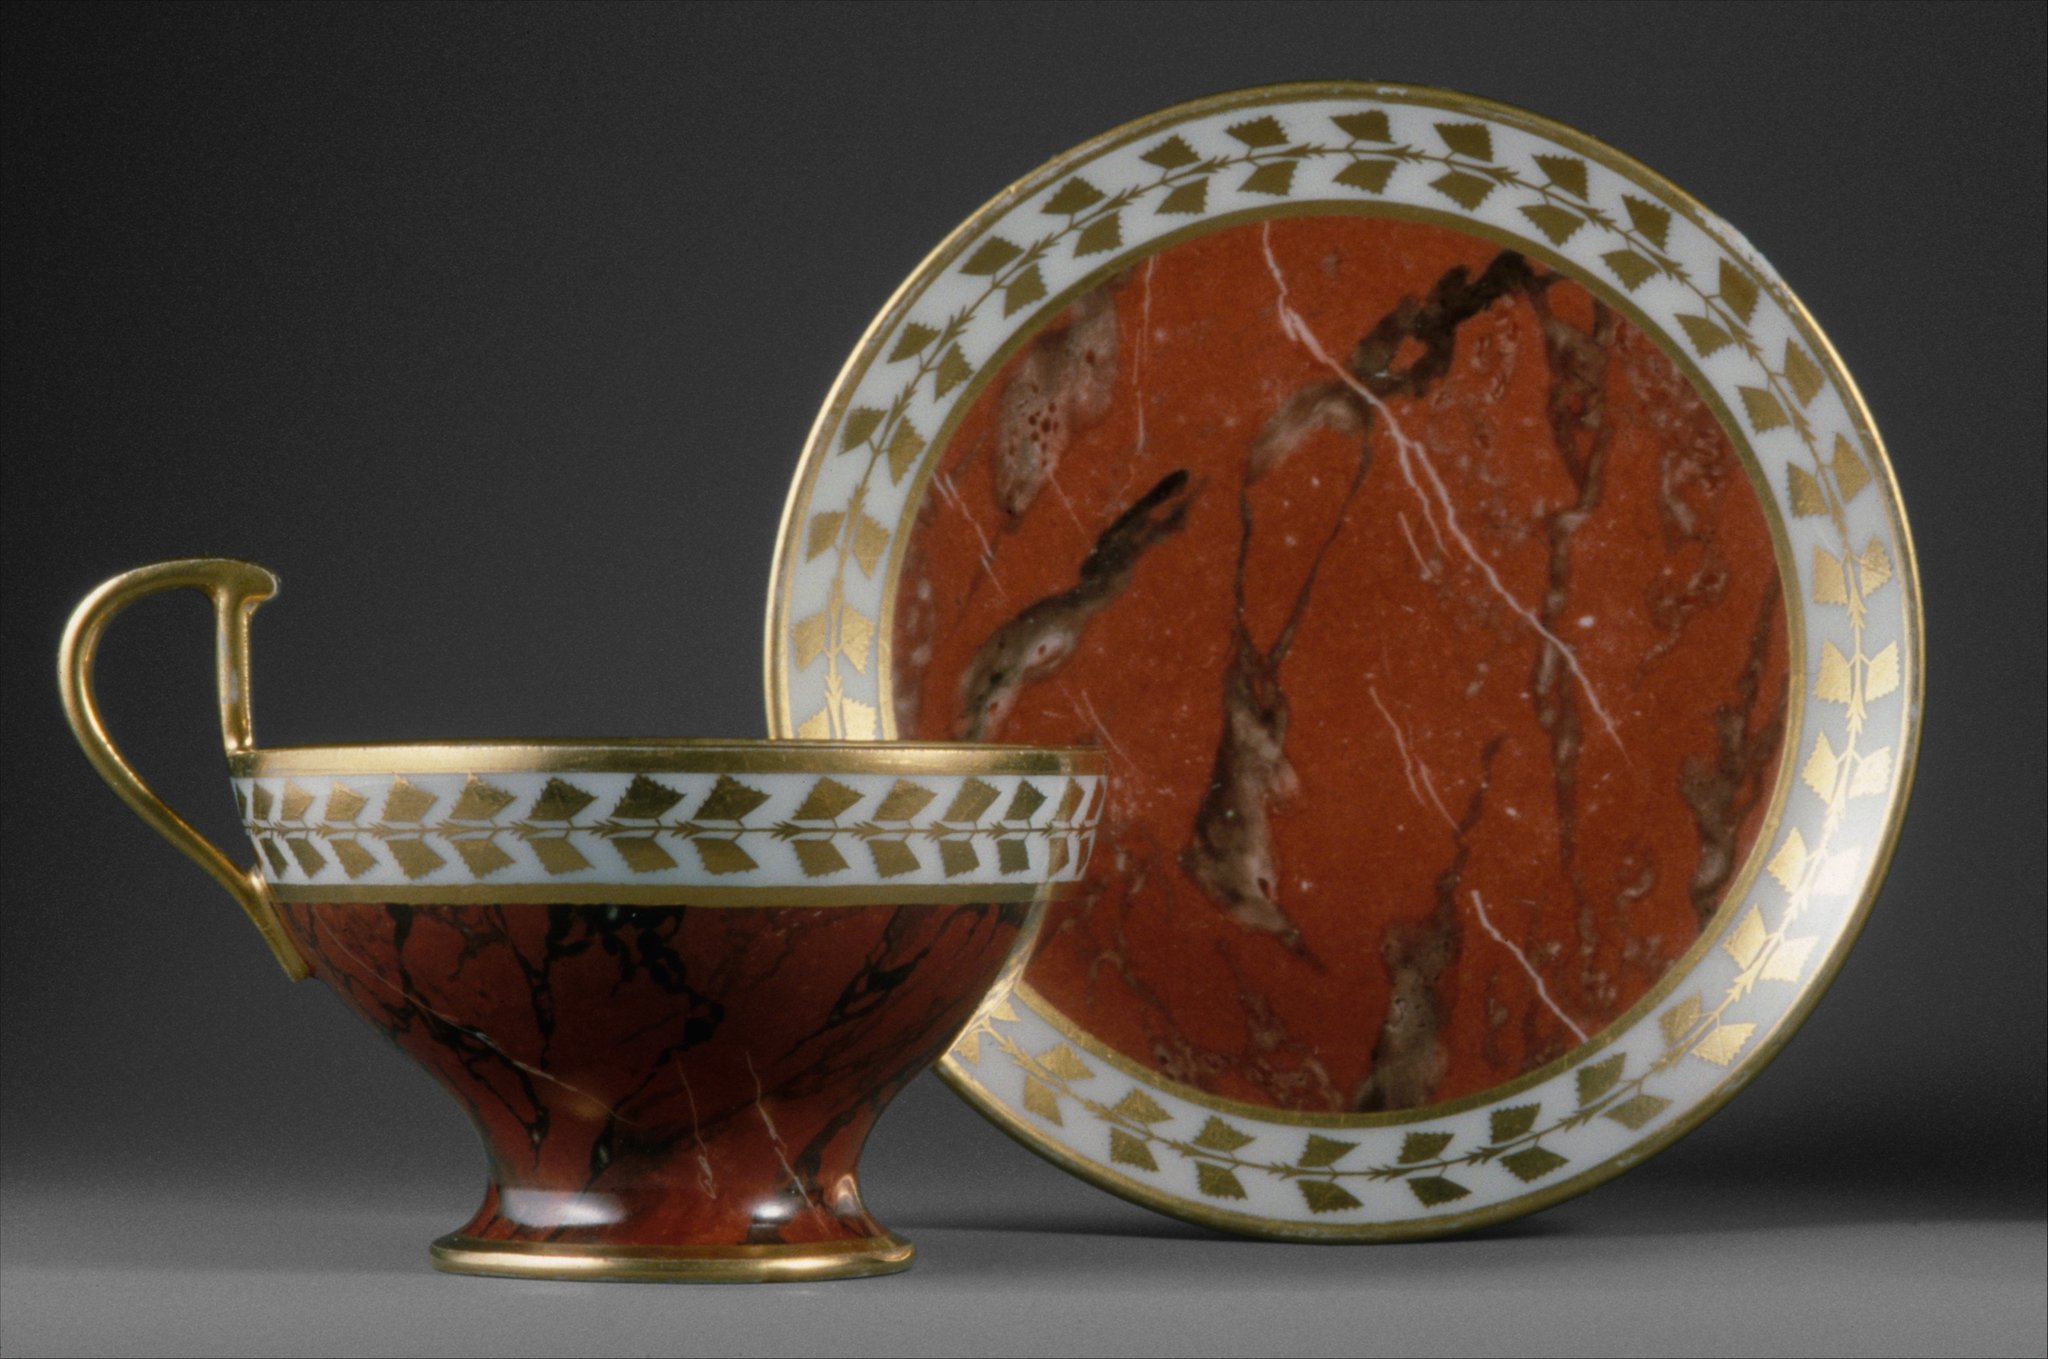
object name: cup and saucer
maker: sèvres manufactory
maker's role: manufactory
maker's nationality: french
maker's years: 1740-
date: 1804-1805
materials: hard paste porcelain